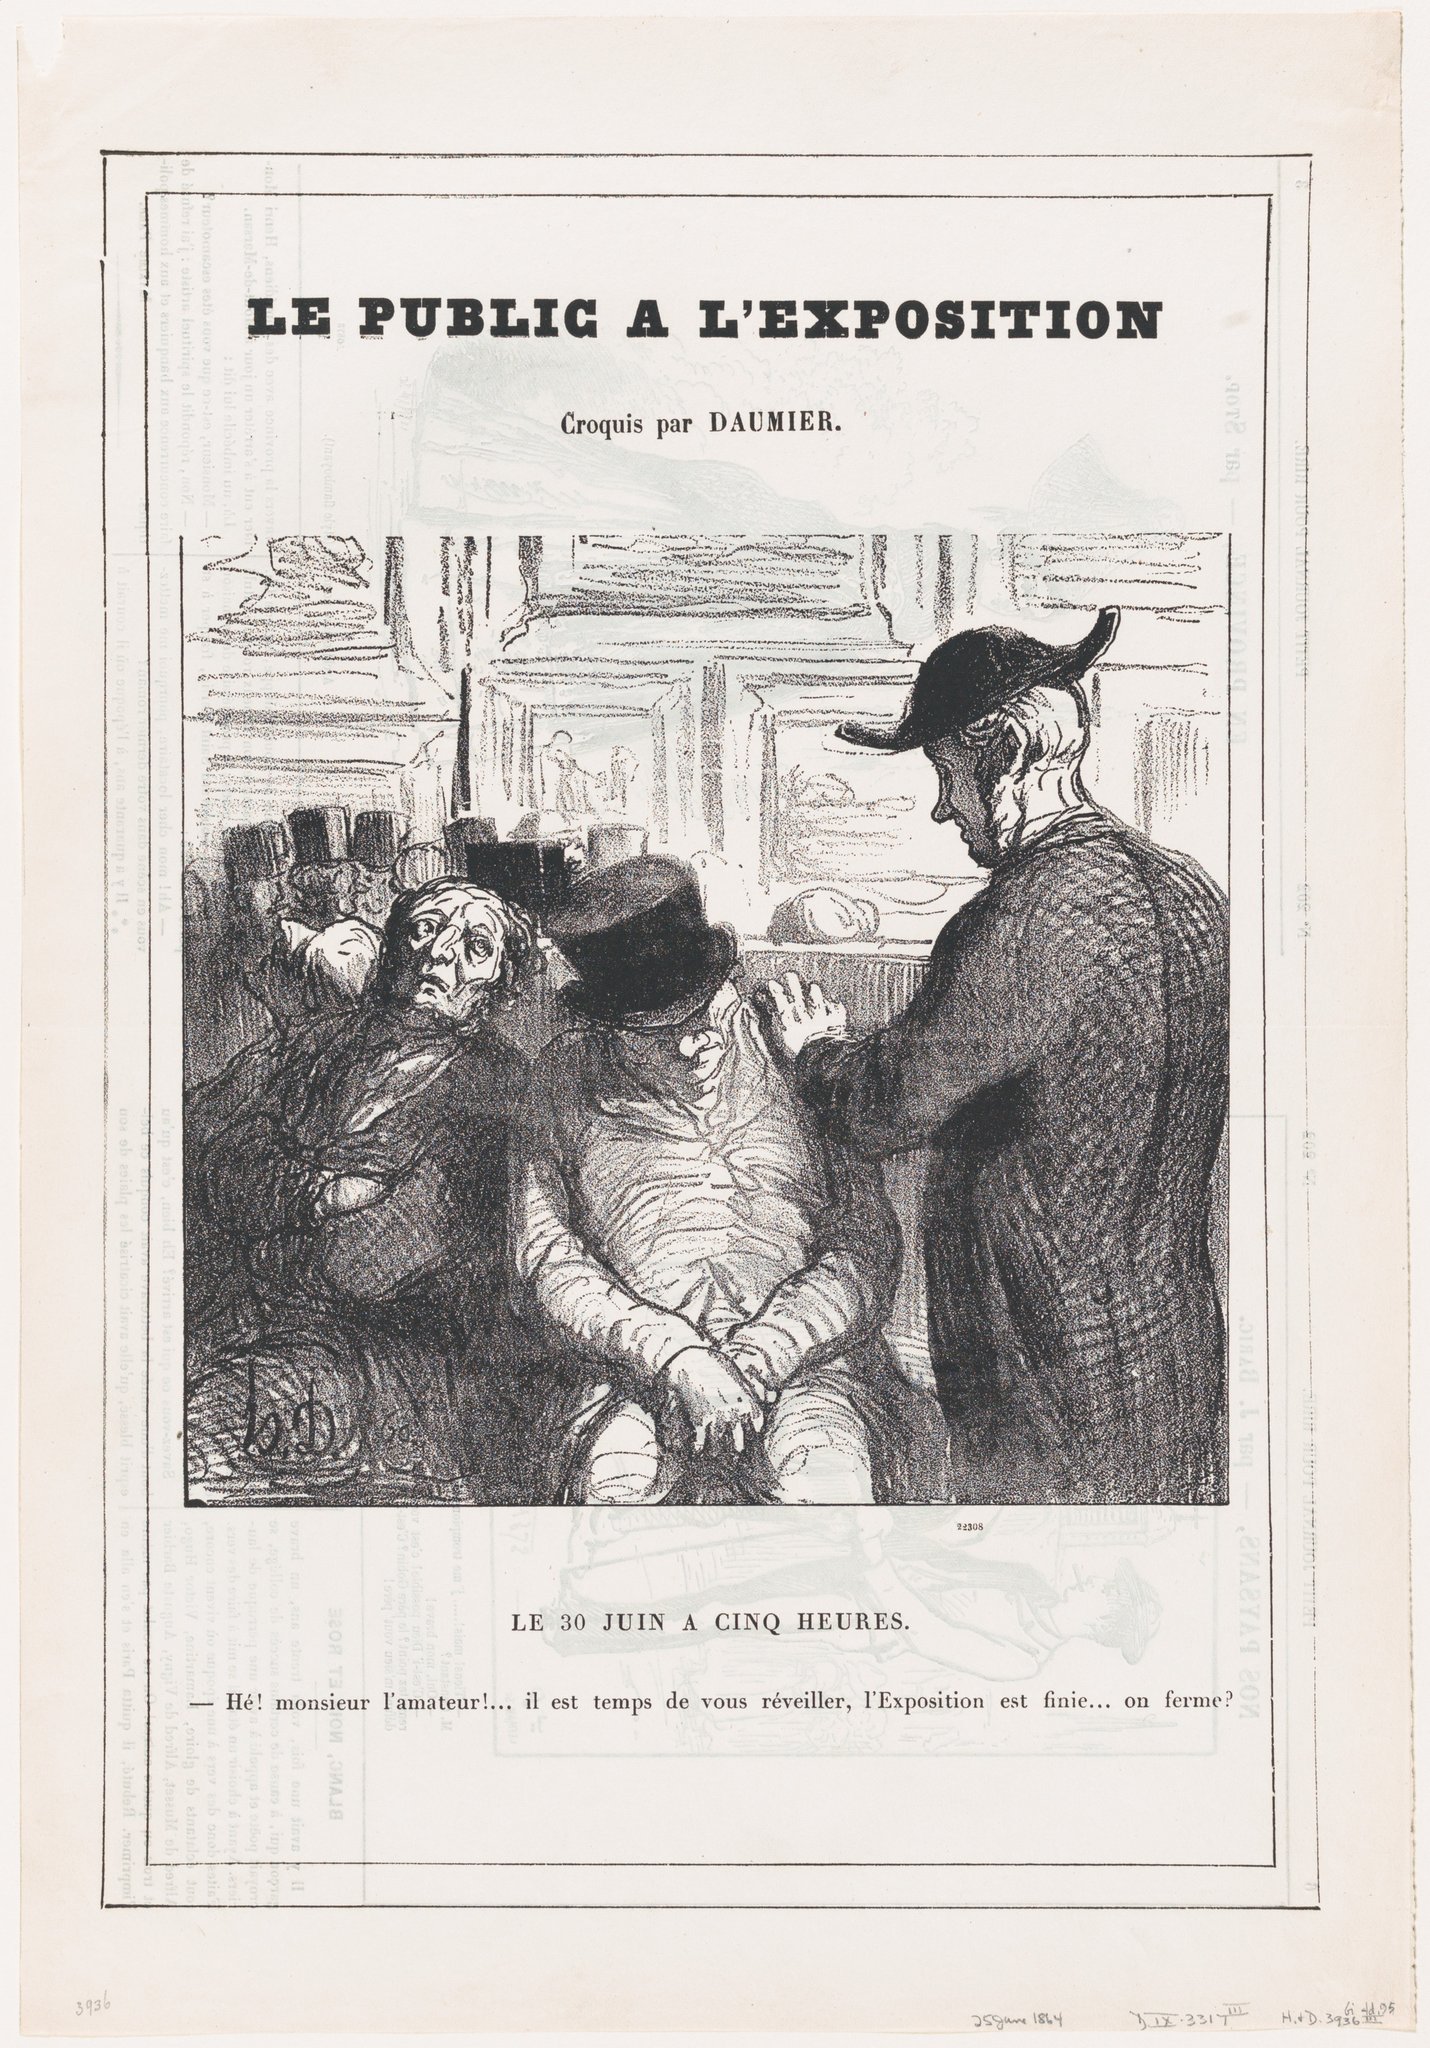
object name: print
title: 5 o'clock on June 30th, from 'The public at the exhibition,' published in Le Petit Journal pour Rire, June 25, 1864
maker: honoré daumier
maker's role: artist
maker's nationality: french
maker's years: 1808-1879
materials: paper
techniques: lithograph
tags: sleeping,men